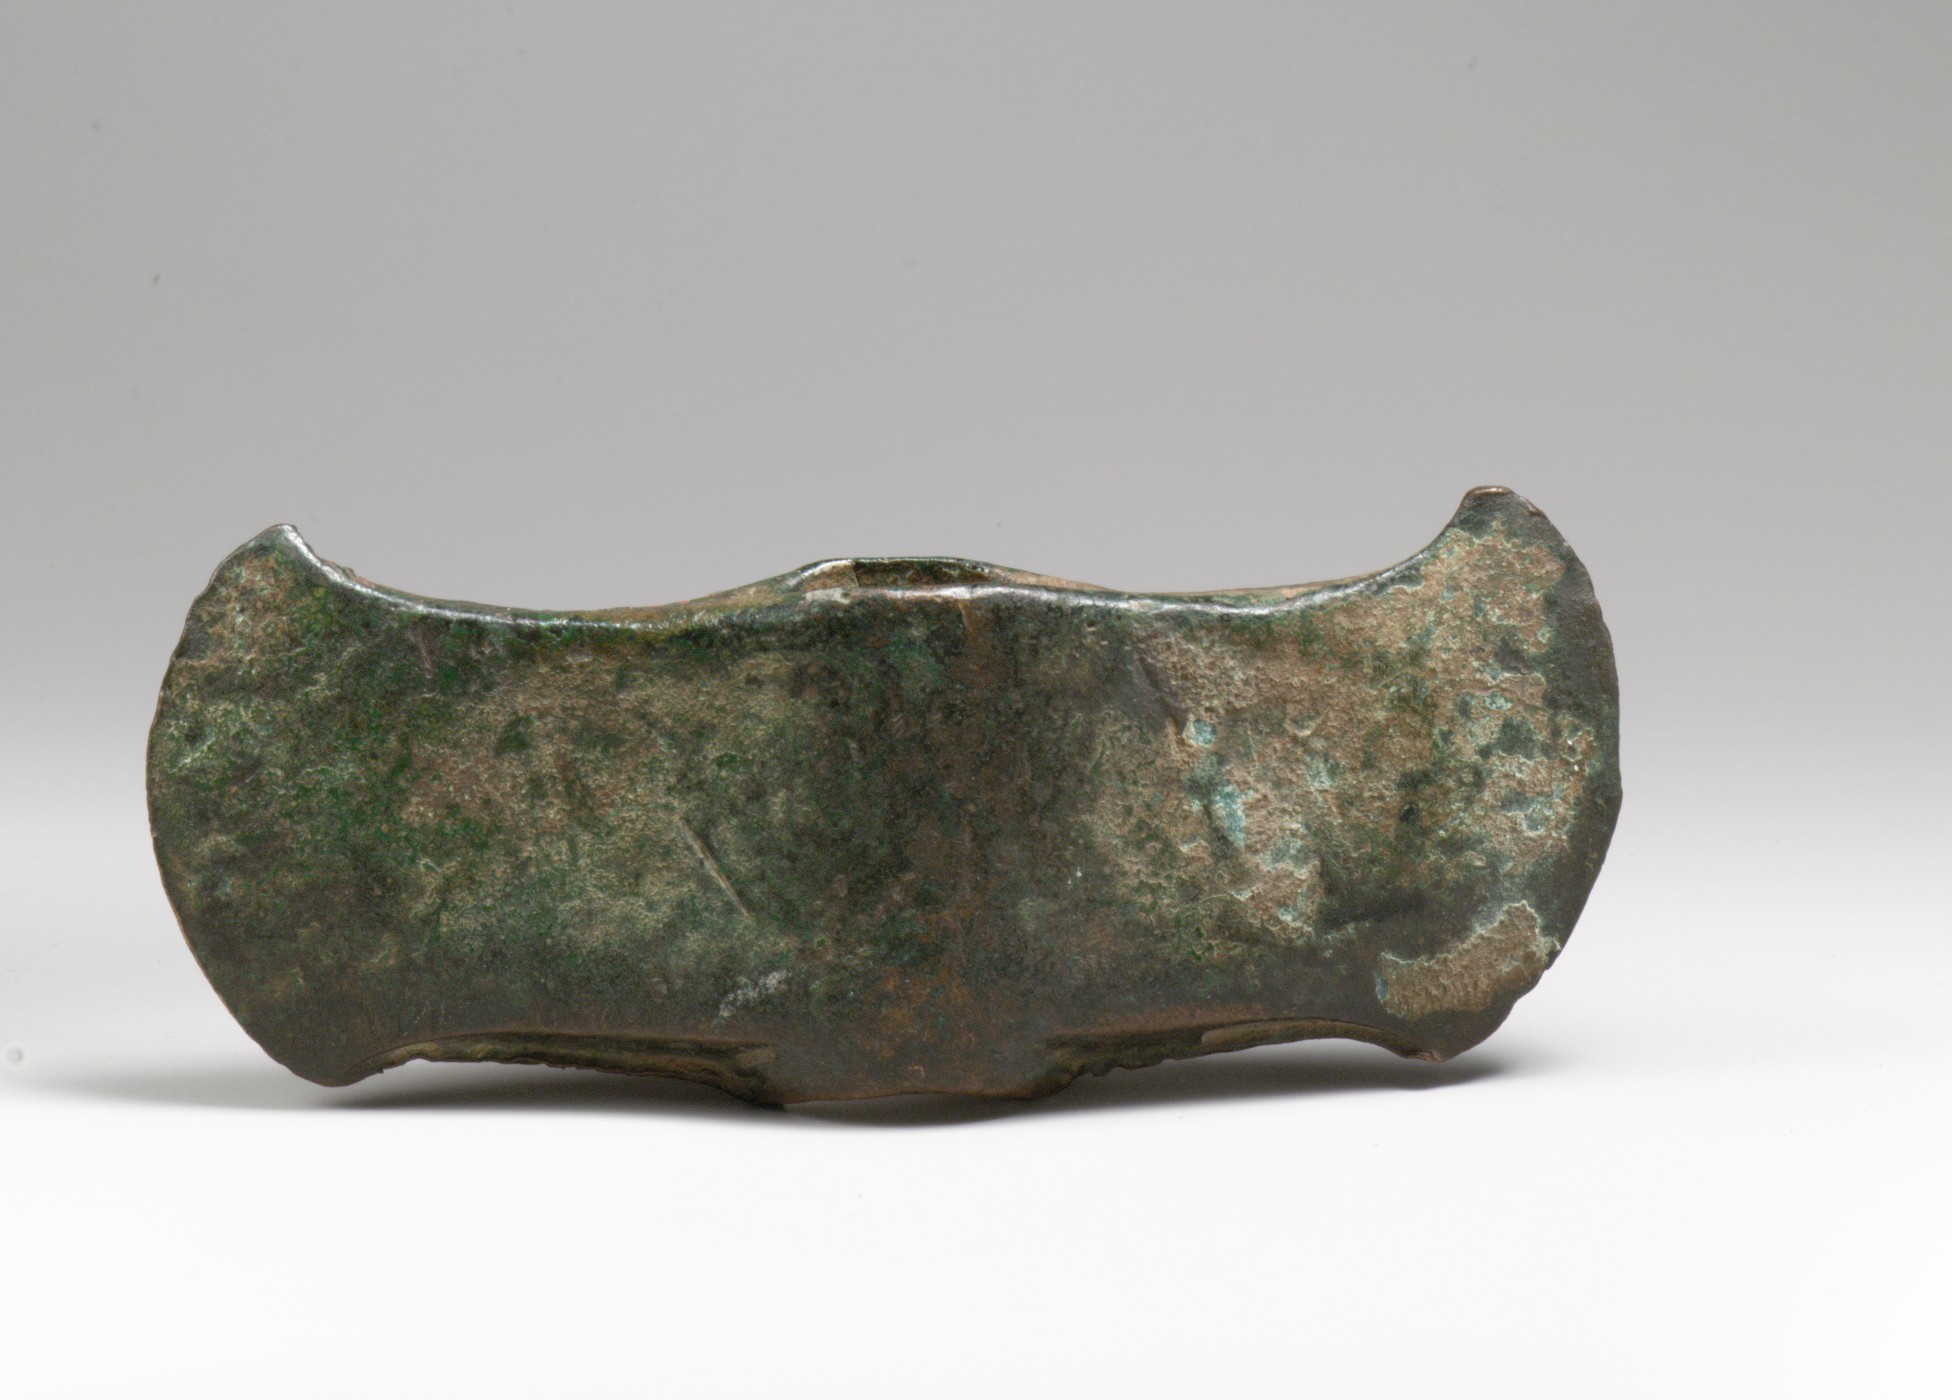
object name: axehead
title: Bronze ax-head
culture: greek or roman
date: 7000 BCE-330 CE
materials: bronze